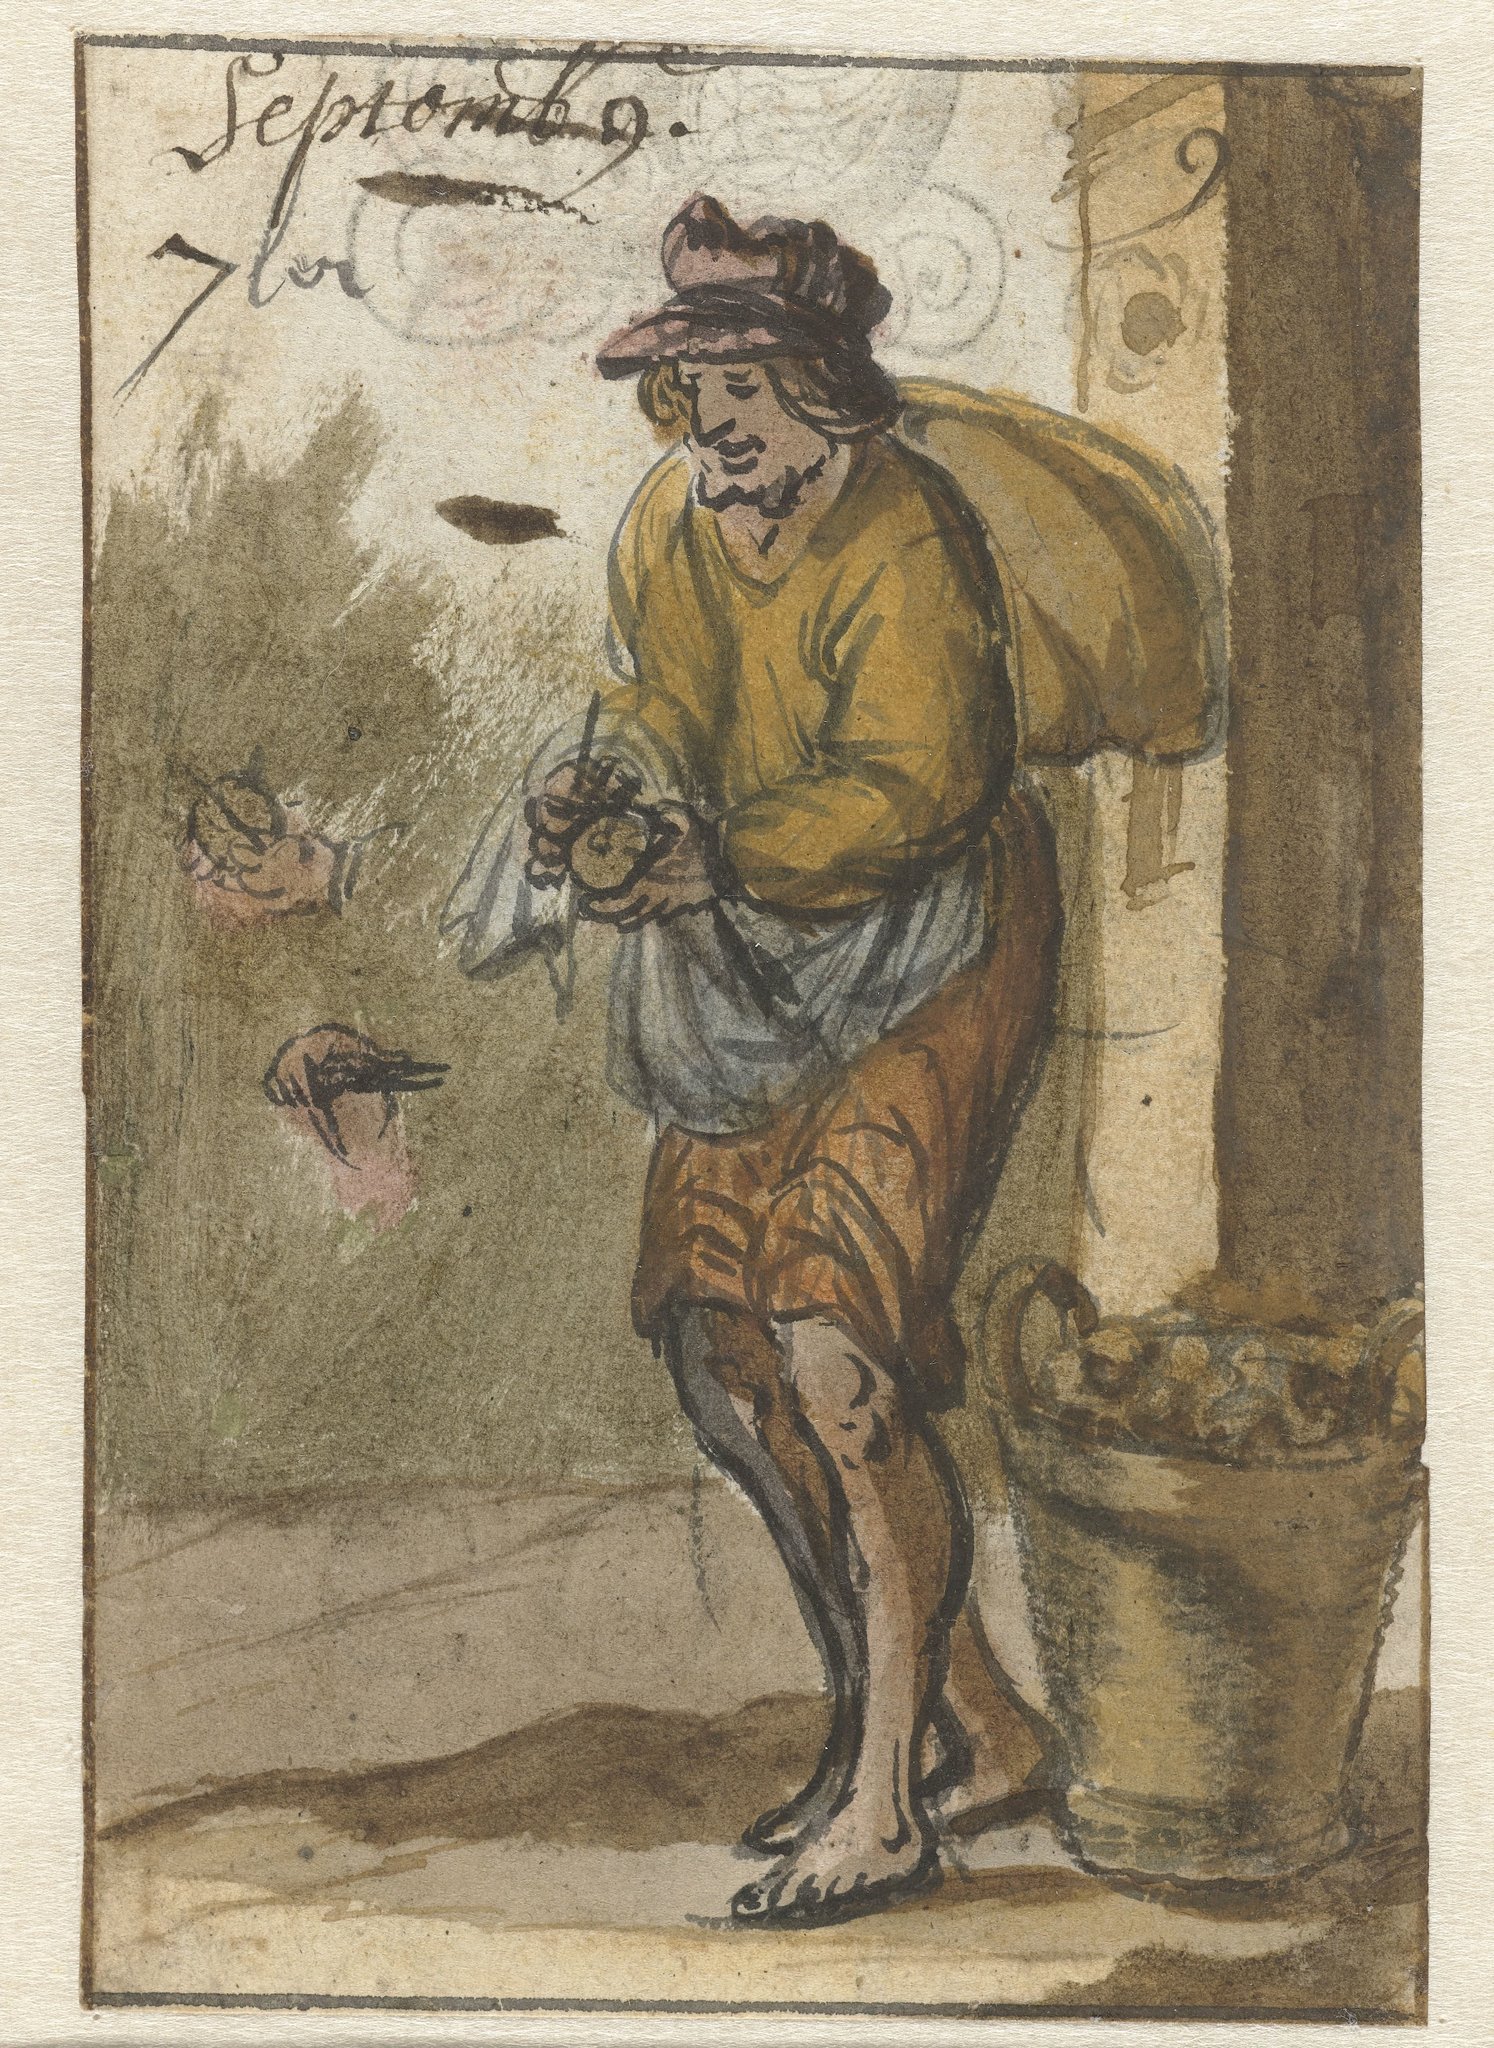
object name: drawing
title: September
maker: Anonymous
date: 1600-1699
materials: paper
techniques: brush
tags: september and its 'labours', cleaning fruit, e.g. peeling, fruit harvest